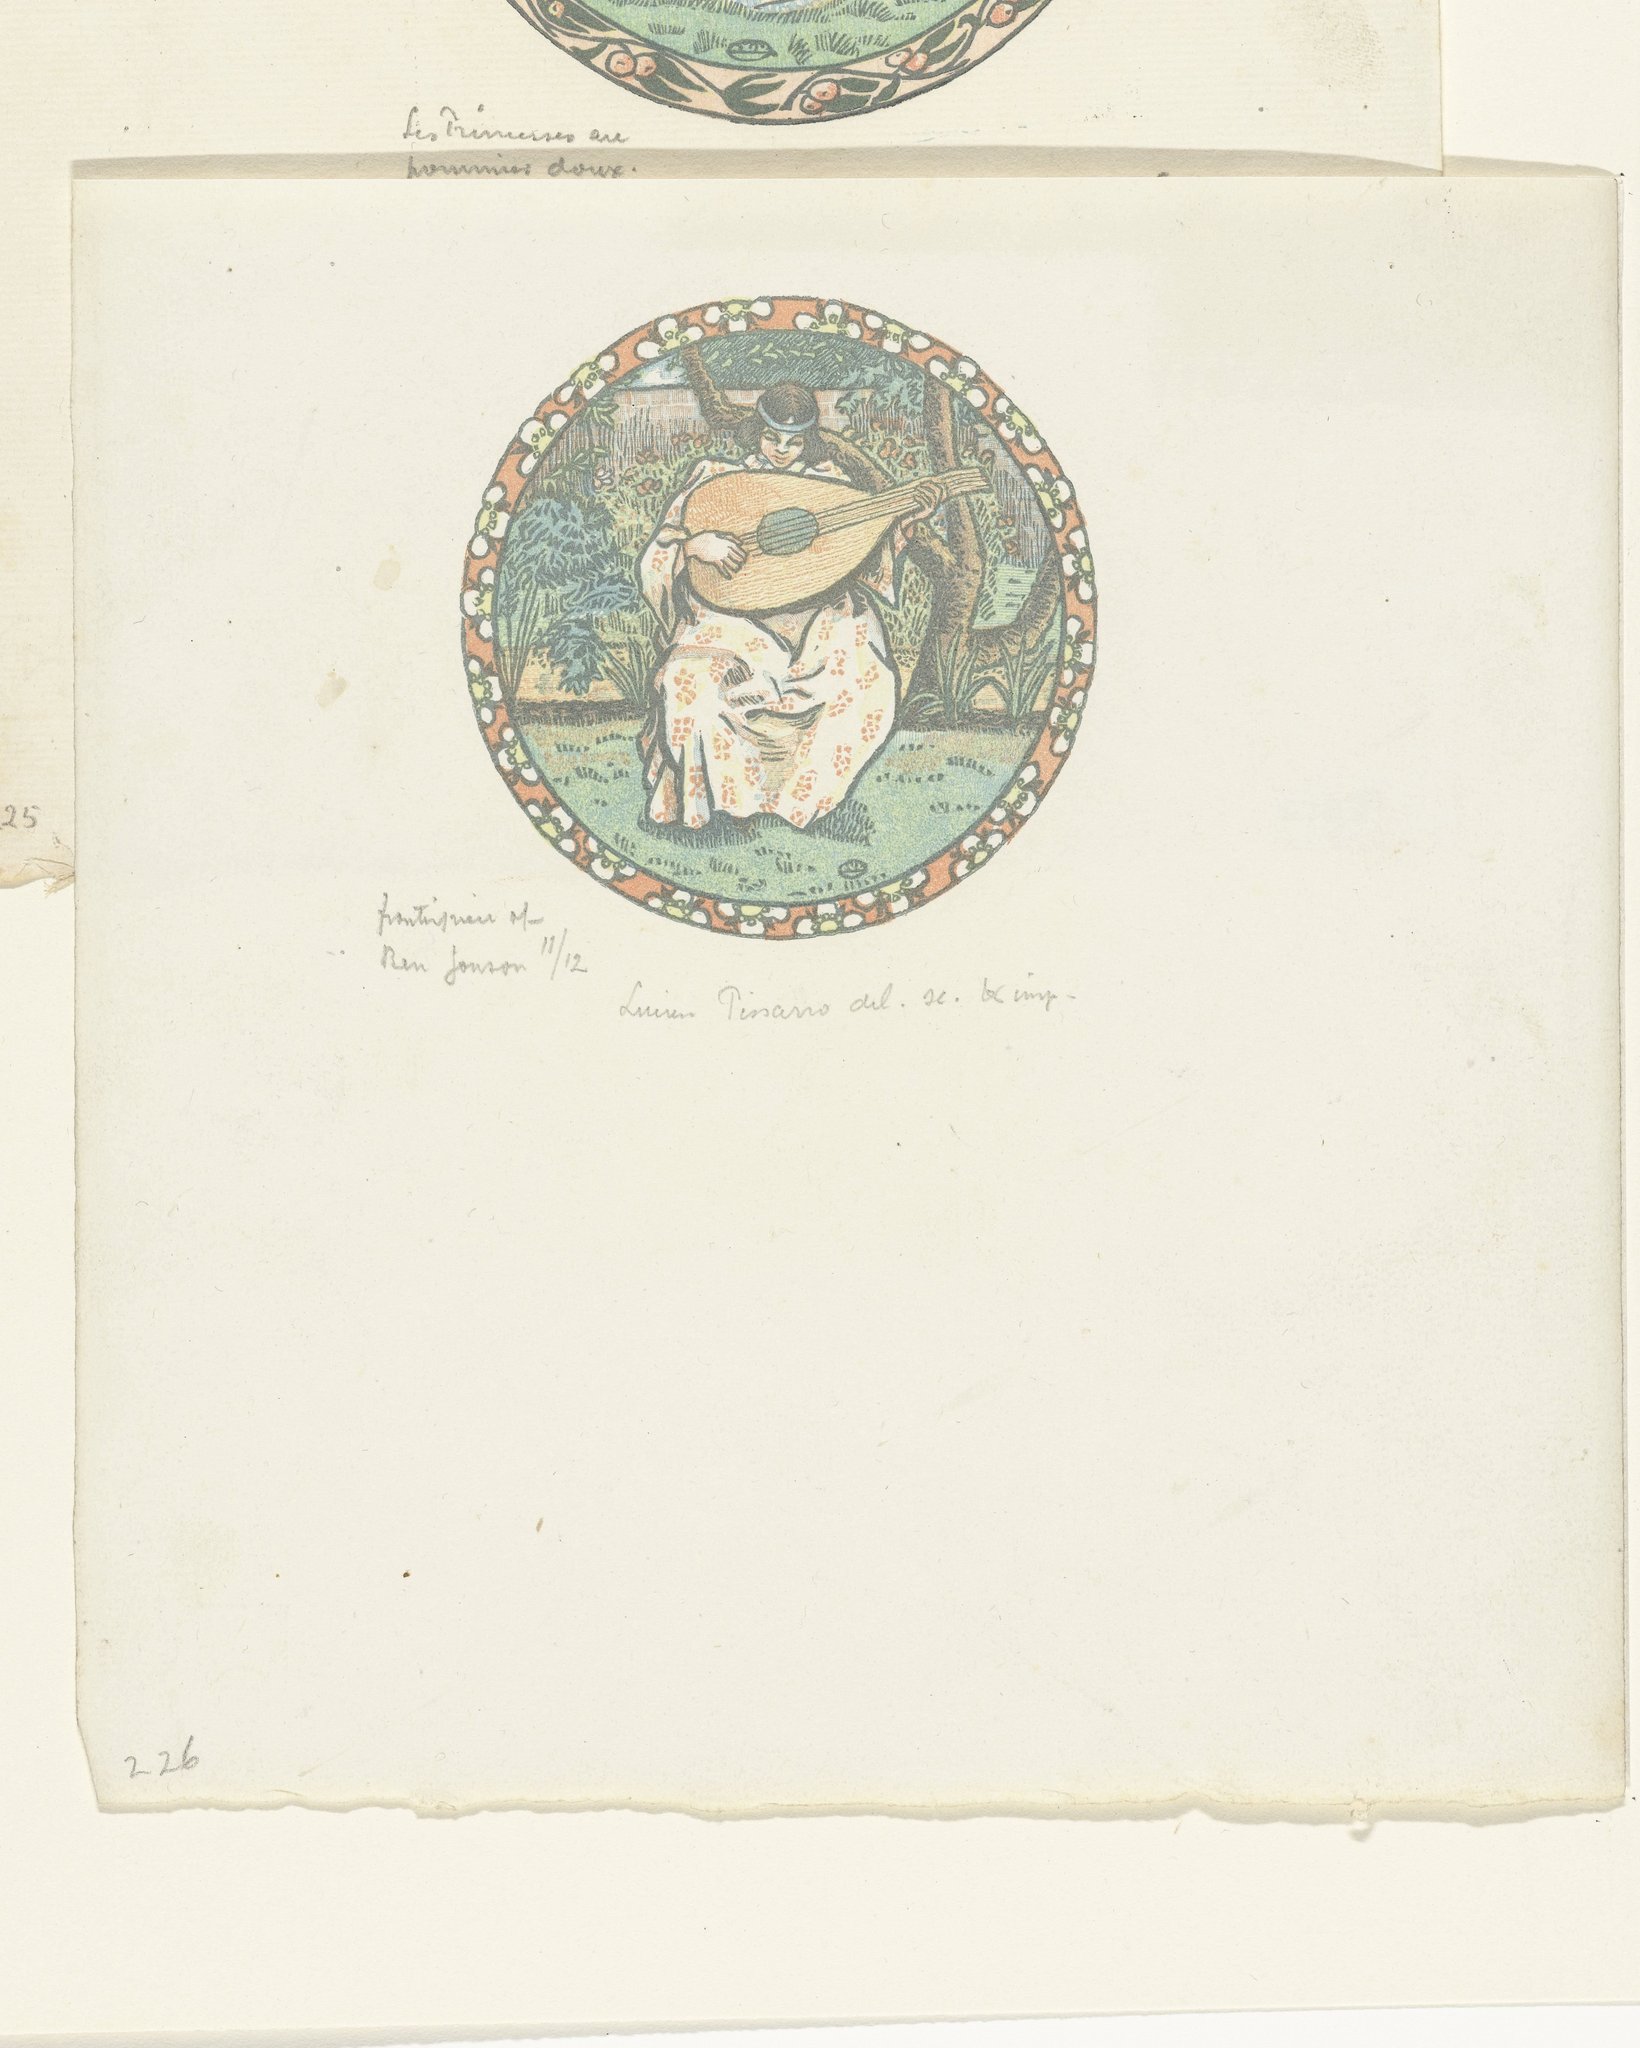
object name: print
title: Luitspeler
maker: lucien pissarro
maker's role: painter, print maker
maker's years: 1863-1944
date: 1905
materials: paper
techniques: printing, engraving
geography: england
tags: one person playing string instrument (plucked), lute, and special forms of lute, e.g.: theorbo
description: Dit is mogelijk een illustratie voor: Robert Steele (ed.), "Some Old Franch and english Ballads", uitgegeven door Eragny (Lucien en Esther Pissarro), Hammersmith 1905. Of het is gemaakt als illustratie voor: Ben Jonson, "Songs of Ben Jonson. A Selection from the Plays, Masques, and Poems, with the Earliest Known Settings of Certain Numbers", uitgegeven bij de Eragny Press (Lucien en Esther Pissarro), Hammersmith, 1906. Dit is niet geheel duidelijk. K.Botke